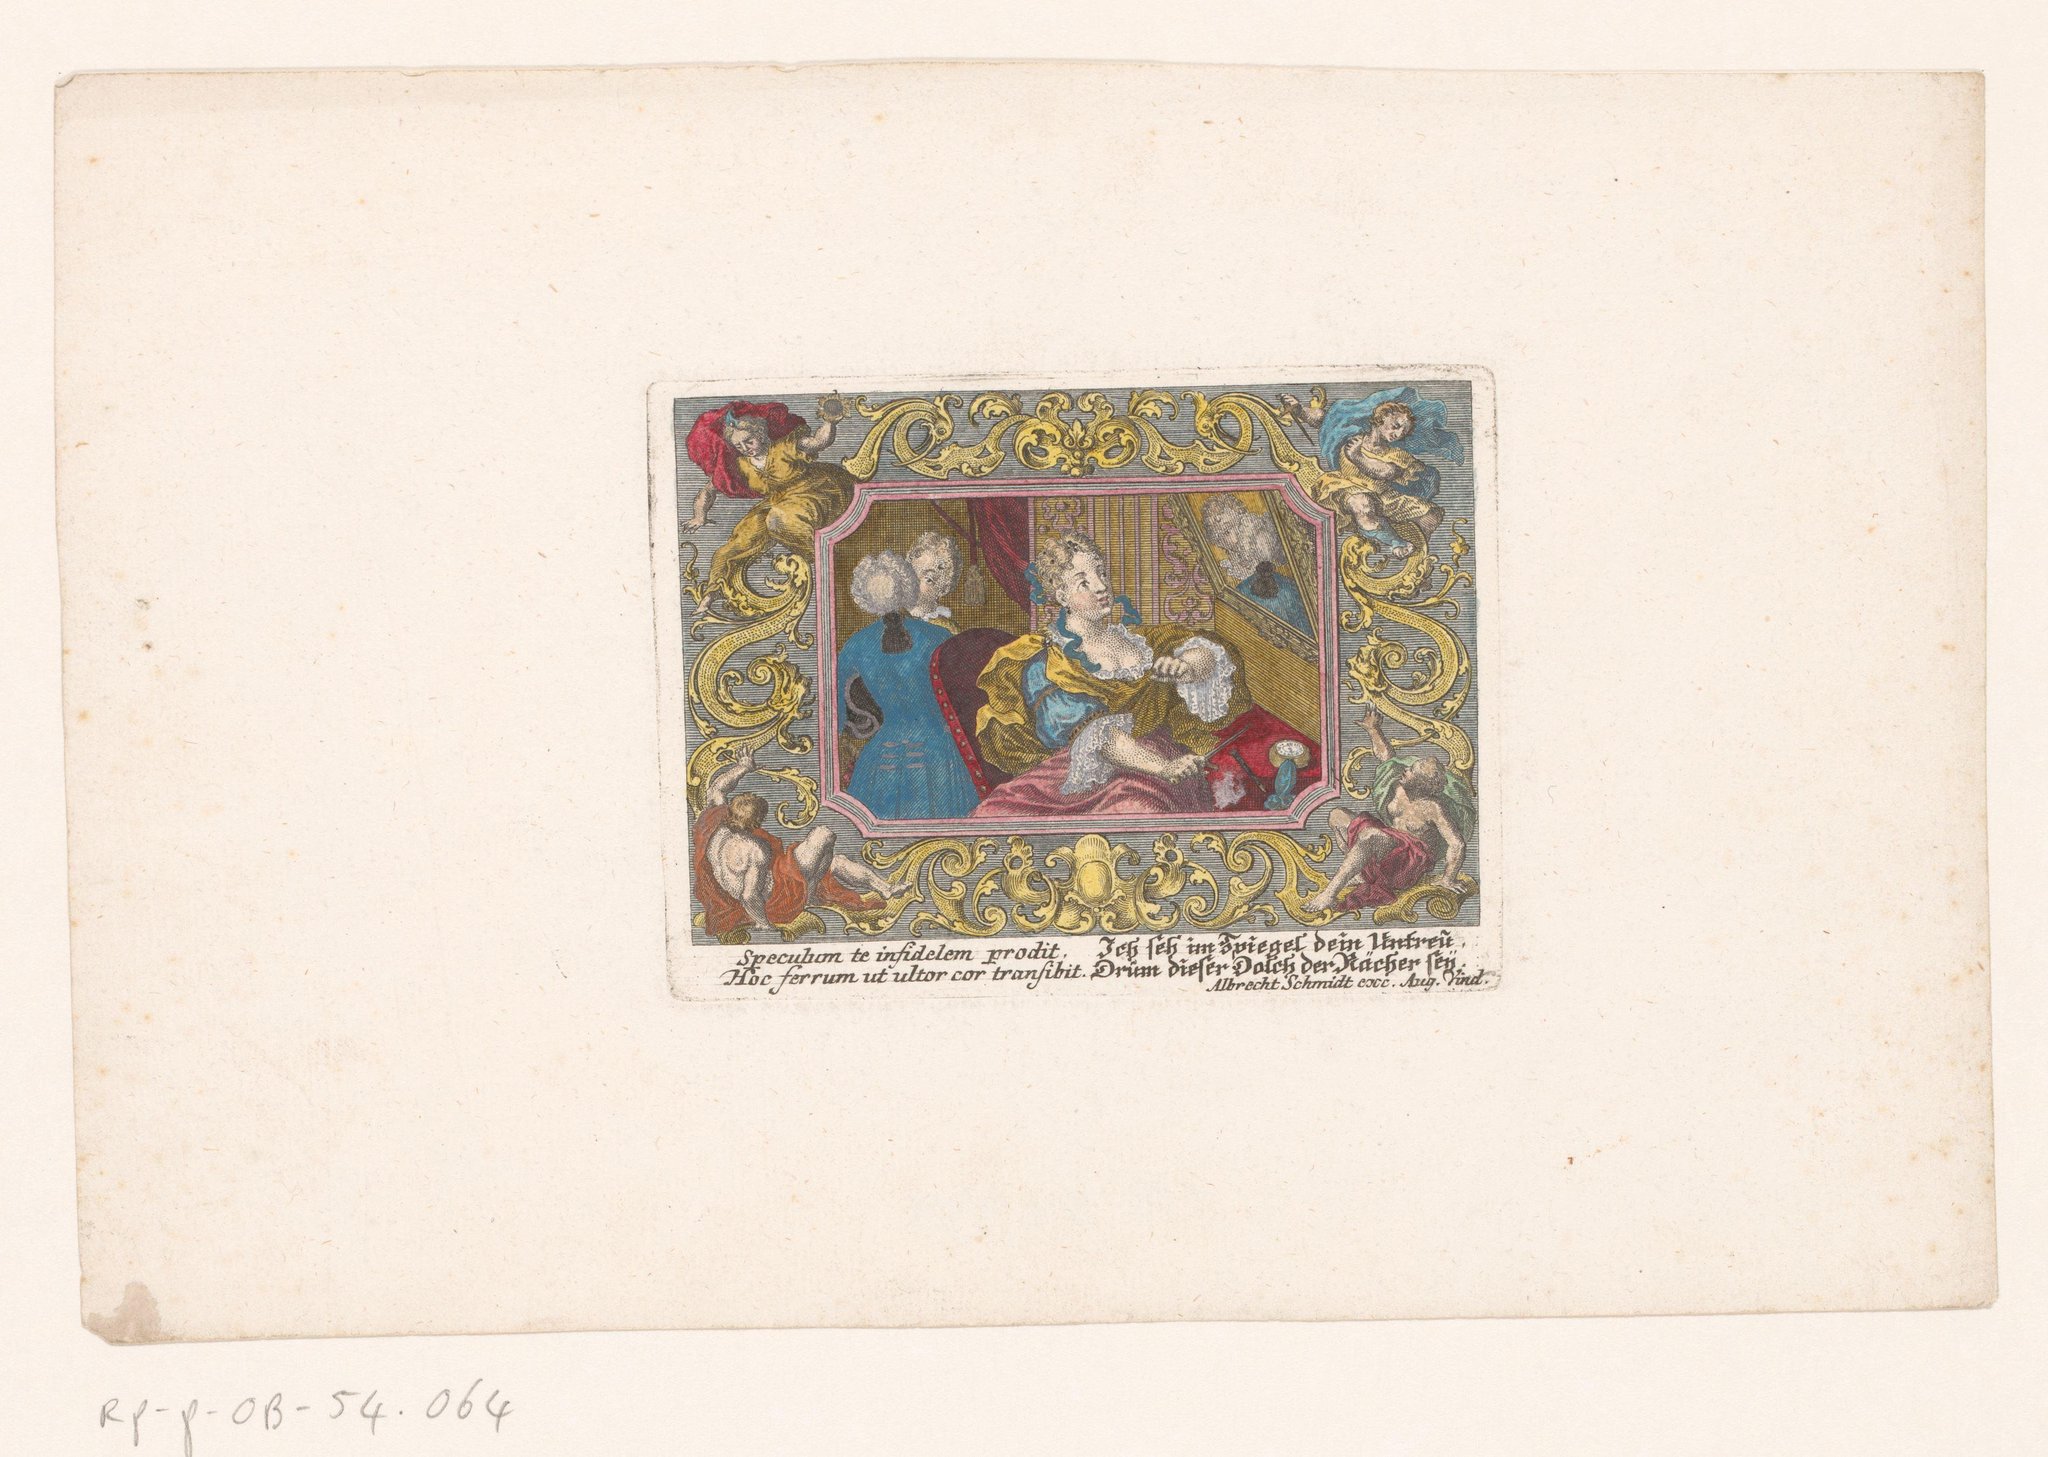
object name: print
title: Zinnebeeld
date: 1677-1744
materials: paper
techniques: etching, hand coloring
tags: chastity, abstract ideas and concepts (+ emblematical representation of concept)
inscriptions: collector's mark: Lugt 2228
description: Vrouw ziet in spiegel ontrouw van haar geliefde.